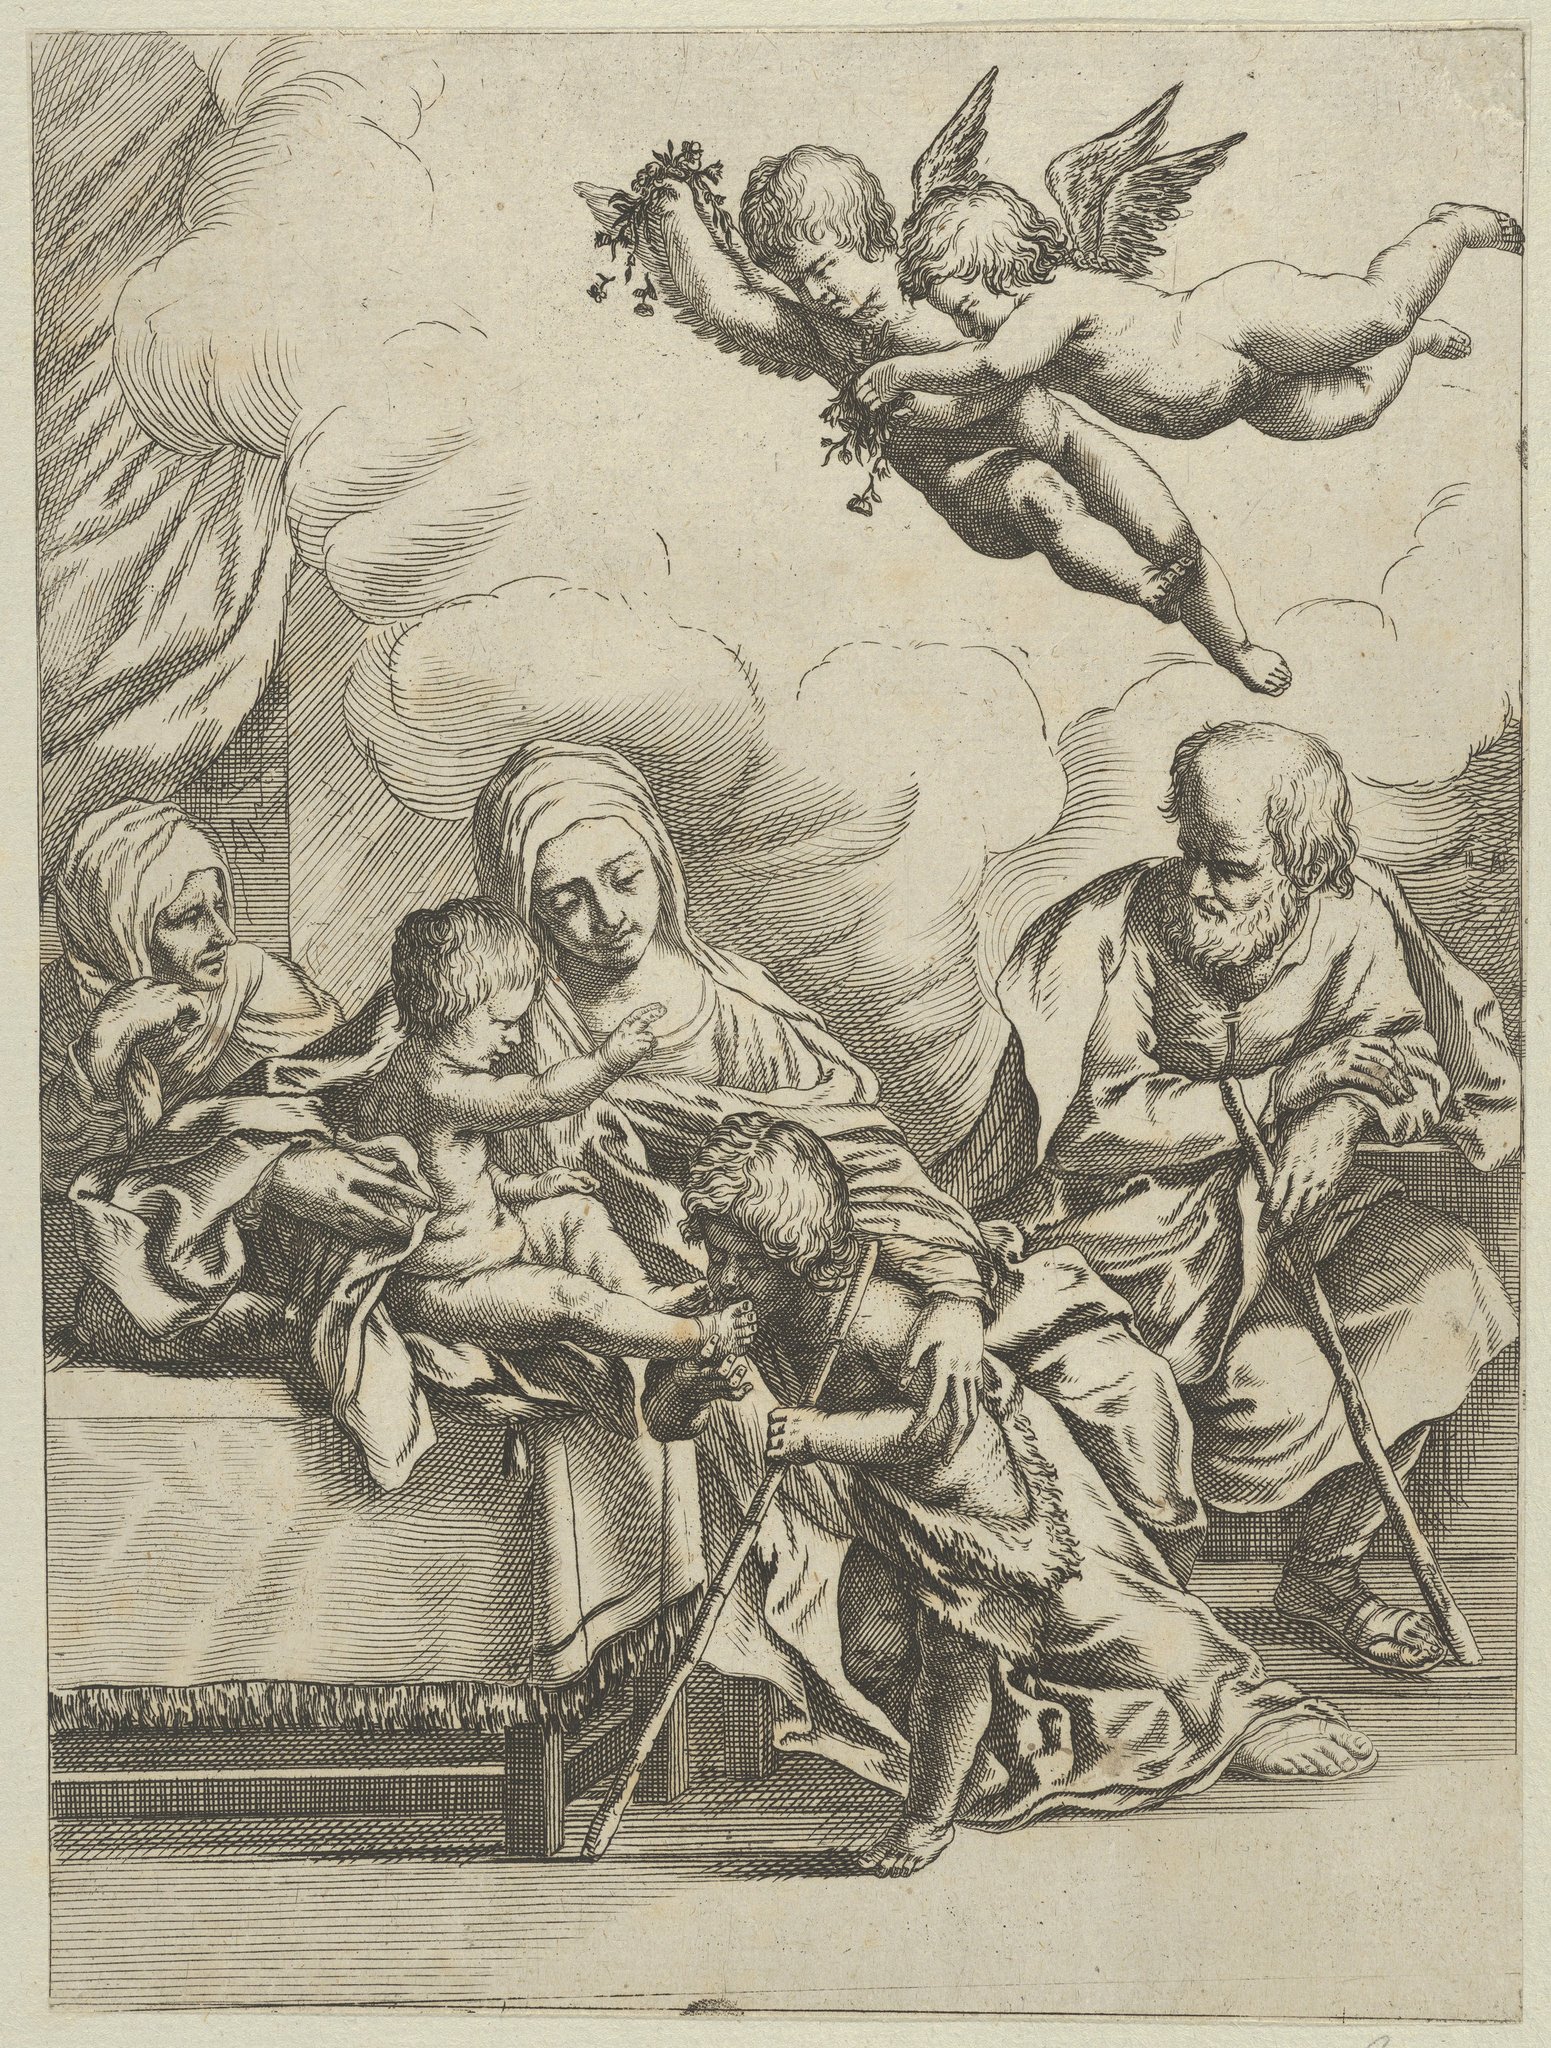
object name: print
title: The Holy Family with young John the Baptist and Saint Elizabeth, two angels above, after Reni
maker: anonymous, 17th century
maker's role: artist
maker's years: 1600-1700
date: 1590-1610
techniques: etching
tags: angels,holy family,saint john the baptist,virgin mary,jesus